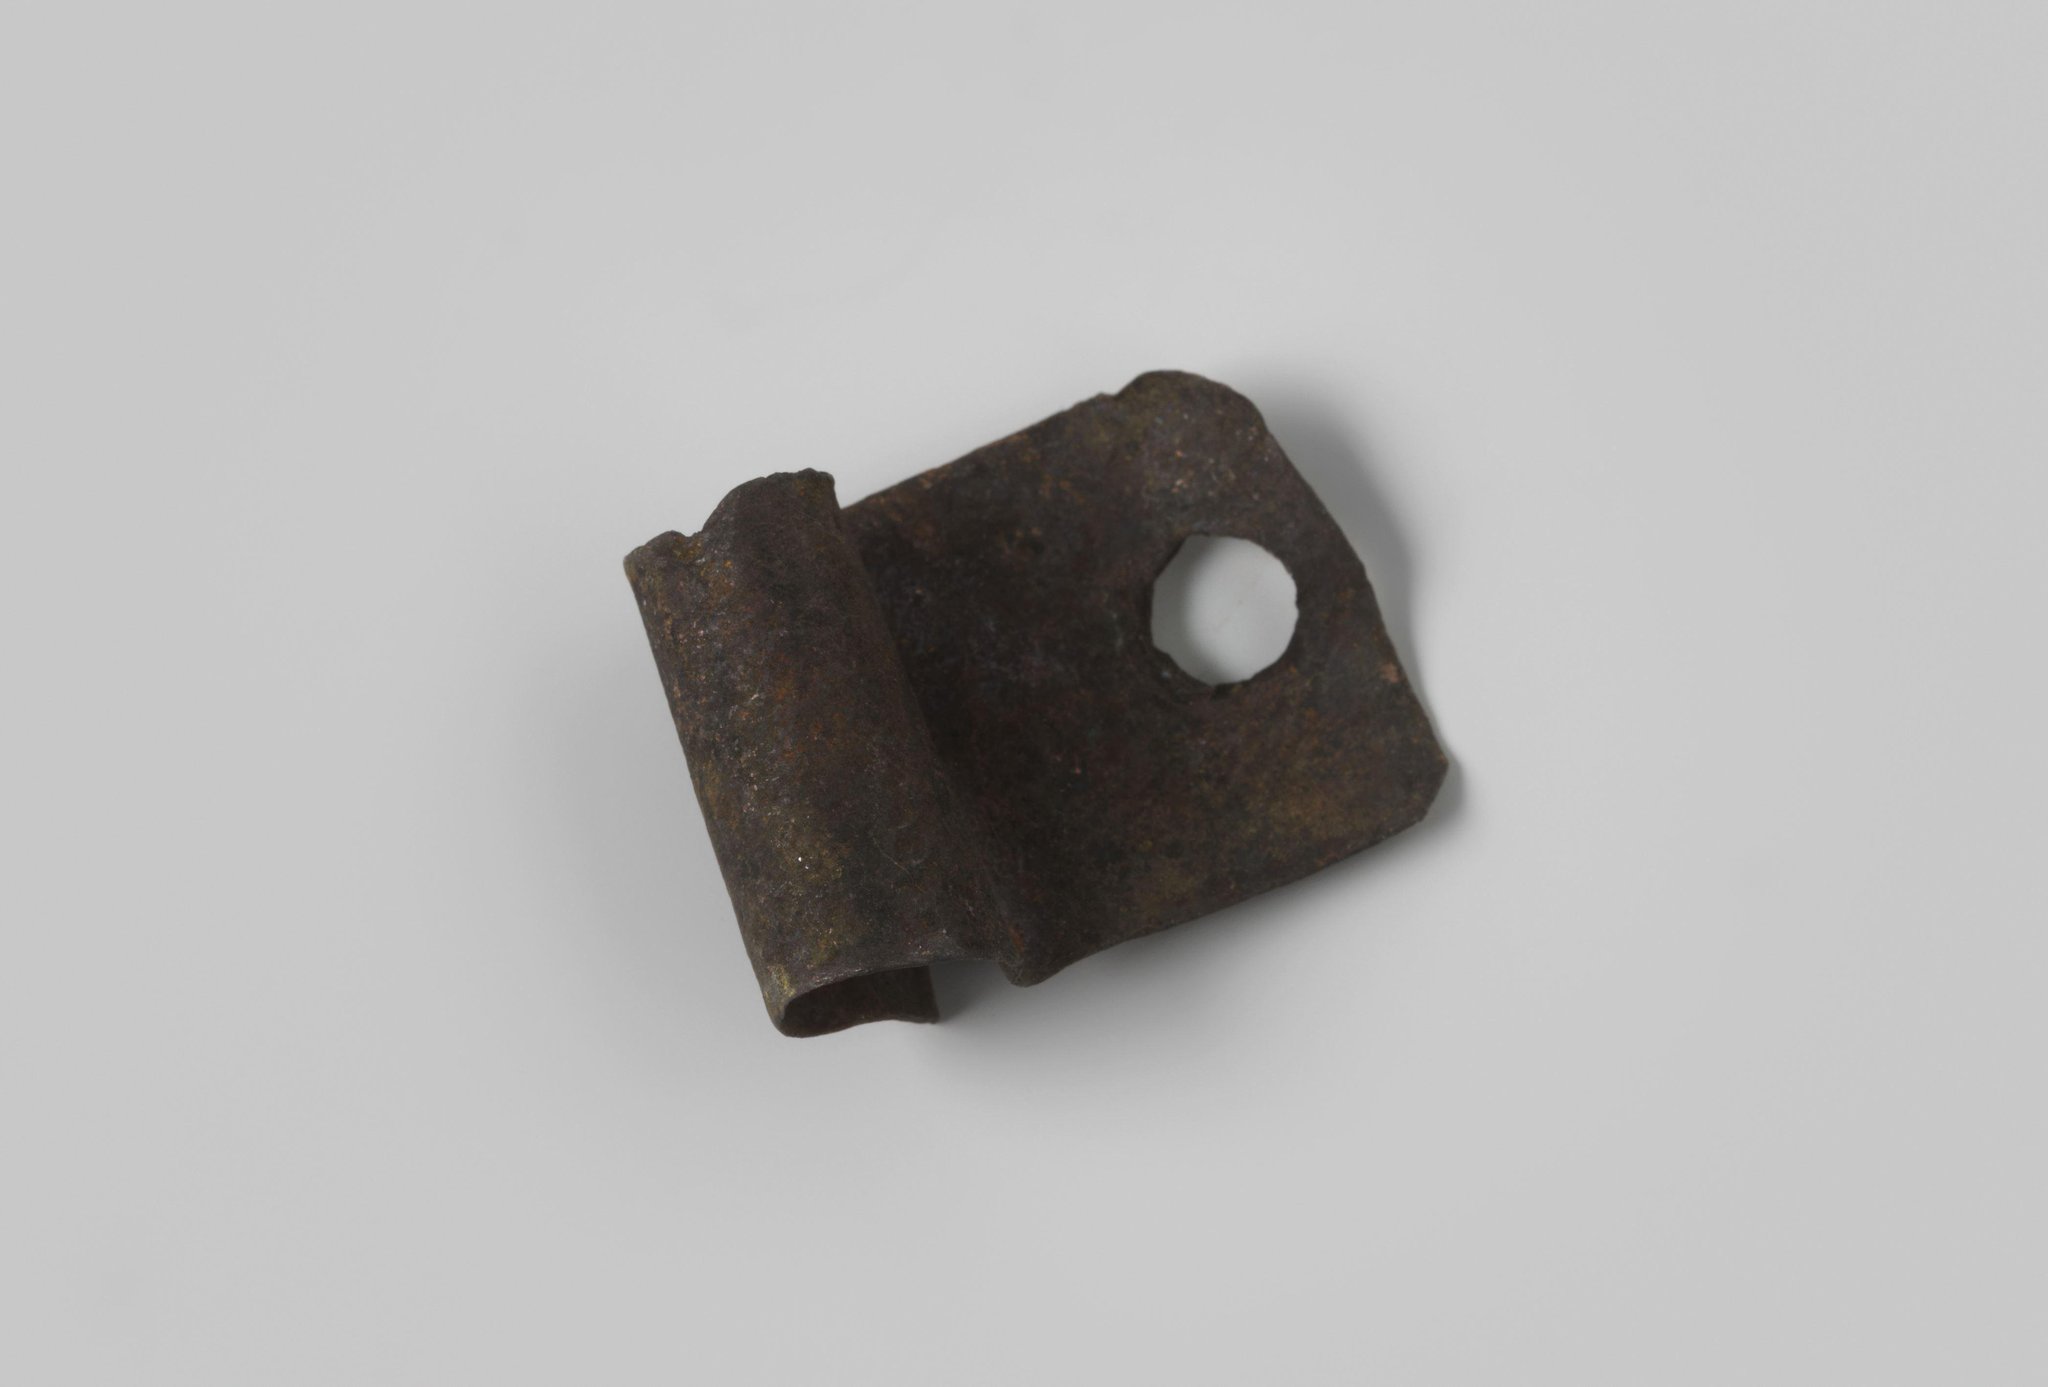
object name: lug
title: Oor van een kardoeskoker uit het wrak van de Oost-Indiëvaarder Hollandia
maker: Anonymous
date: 1700-1743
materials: copper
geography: netherlands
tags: verenigde oostindische compagnie, hollandia (schip), annet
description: Cartridge canister, lug; fragm of strip, sim. NG 1980-27H2394.